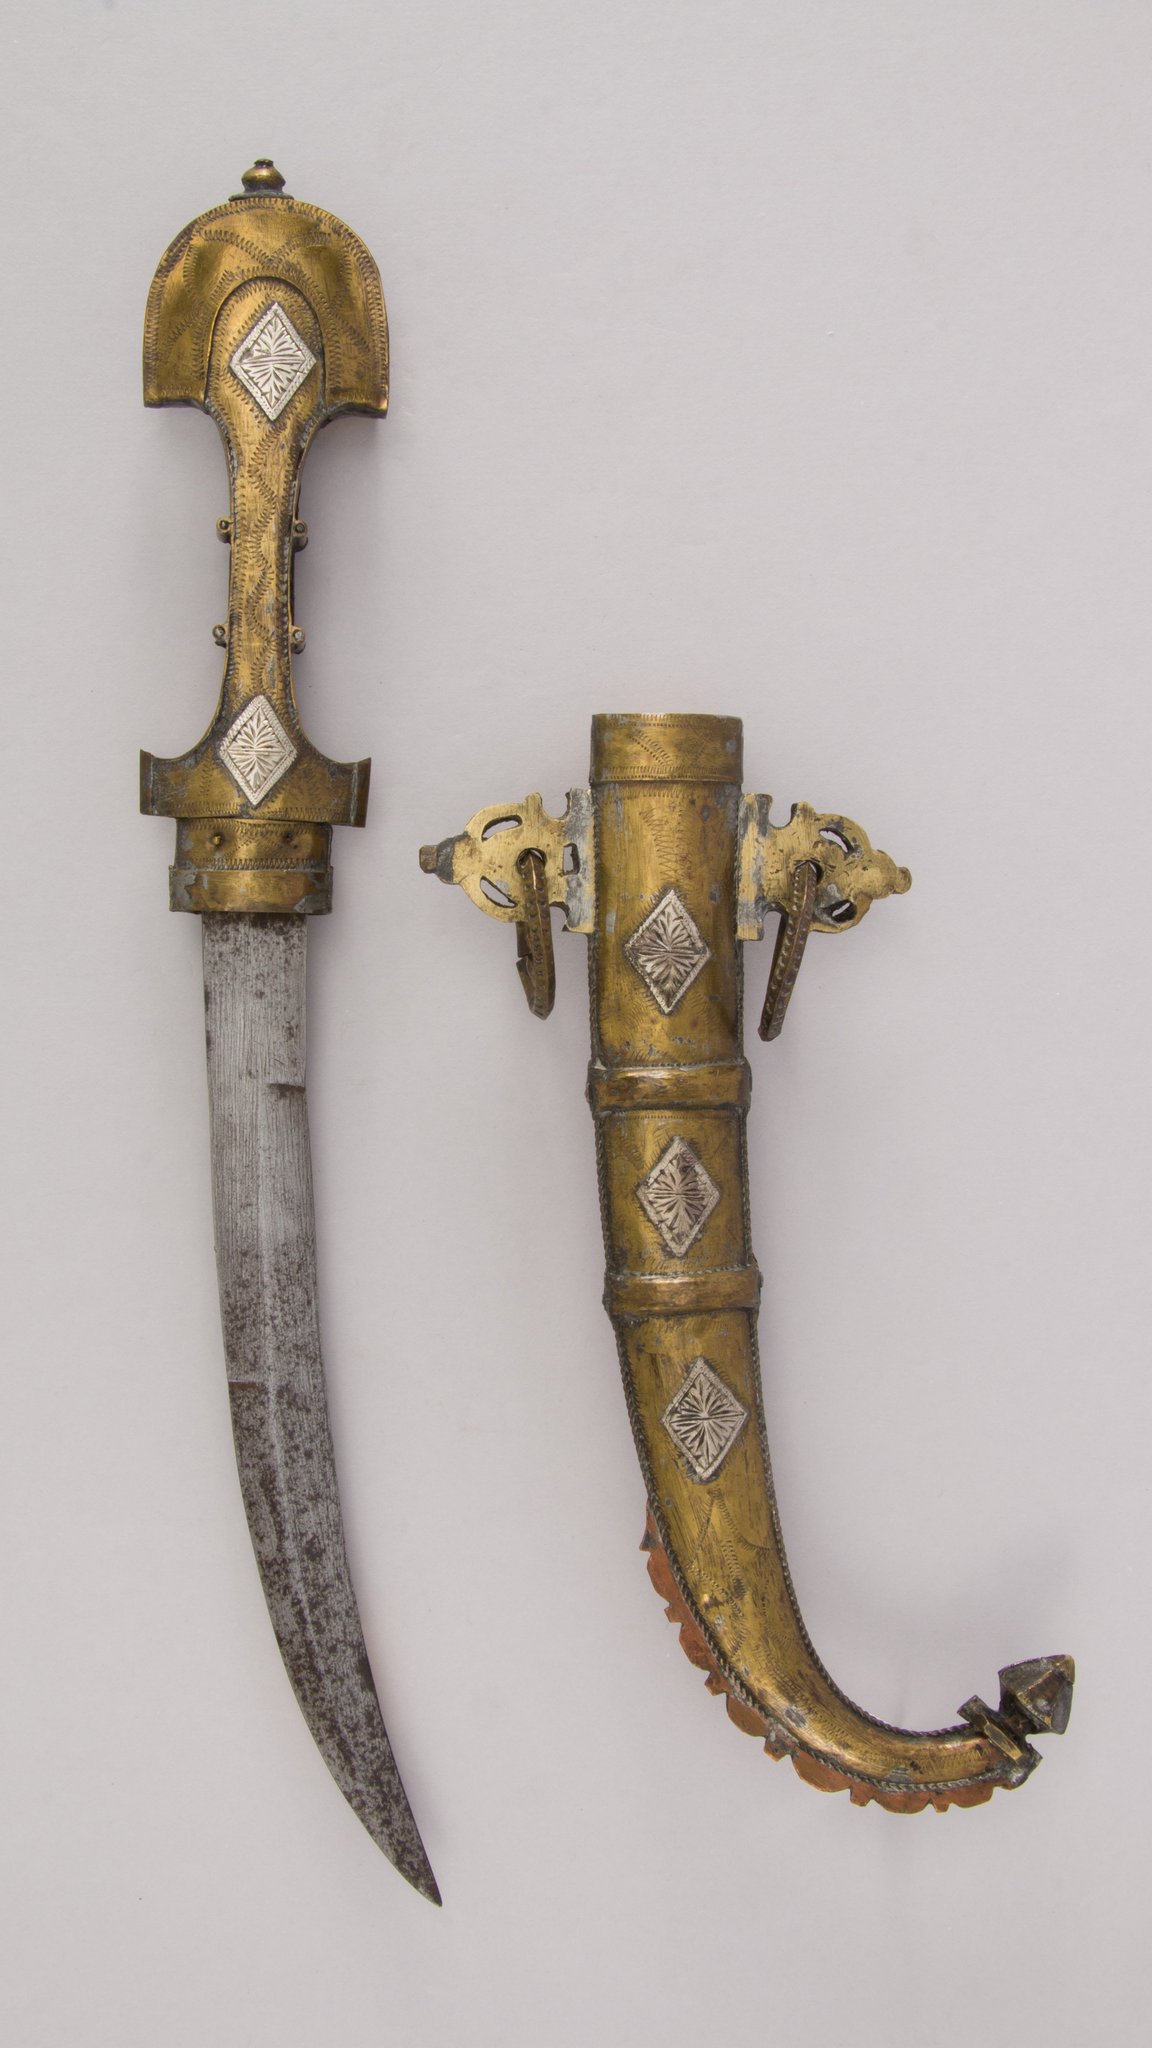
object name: dagger jambiya with sheath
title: Dagger (Jambiya) with Sheath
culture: moroccan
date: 1701-1900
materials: glass, silver, steel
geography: morocco